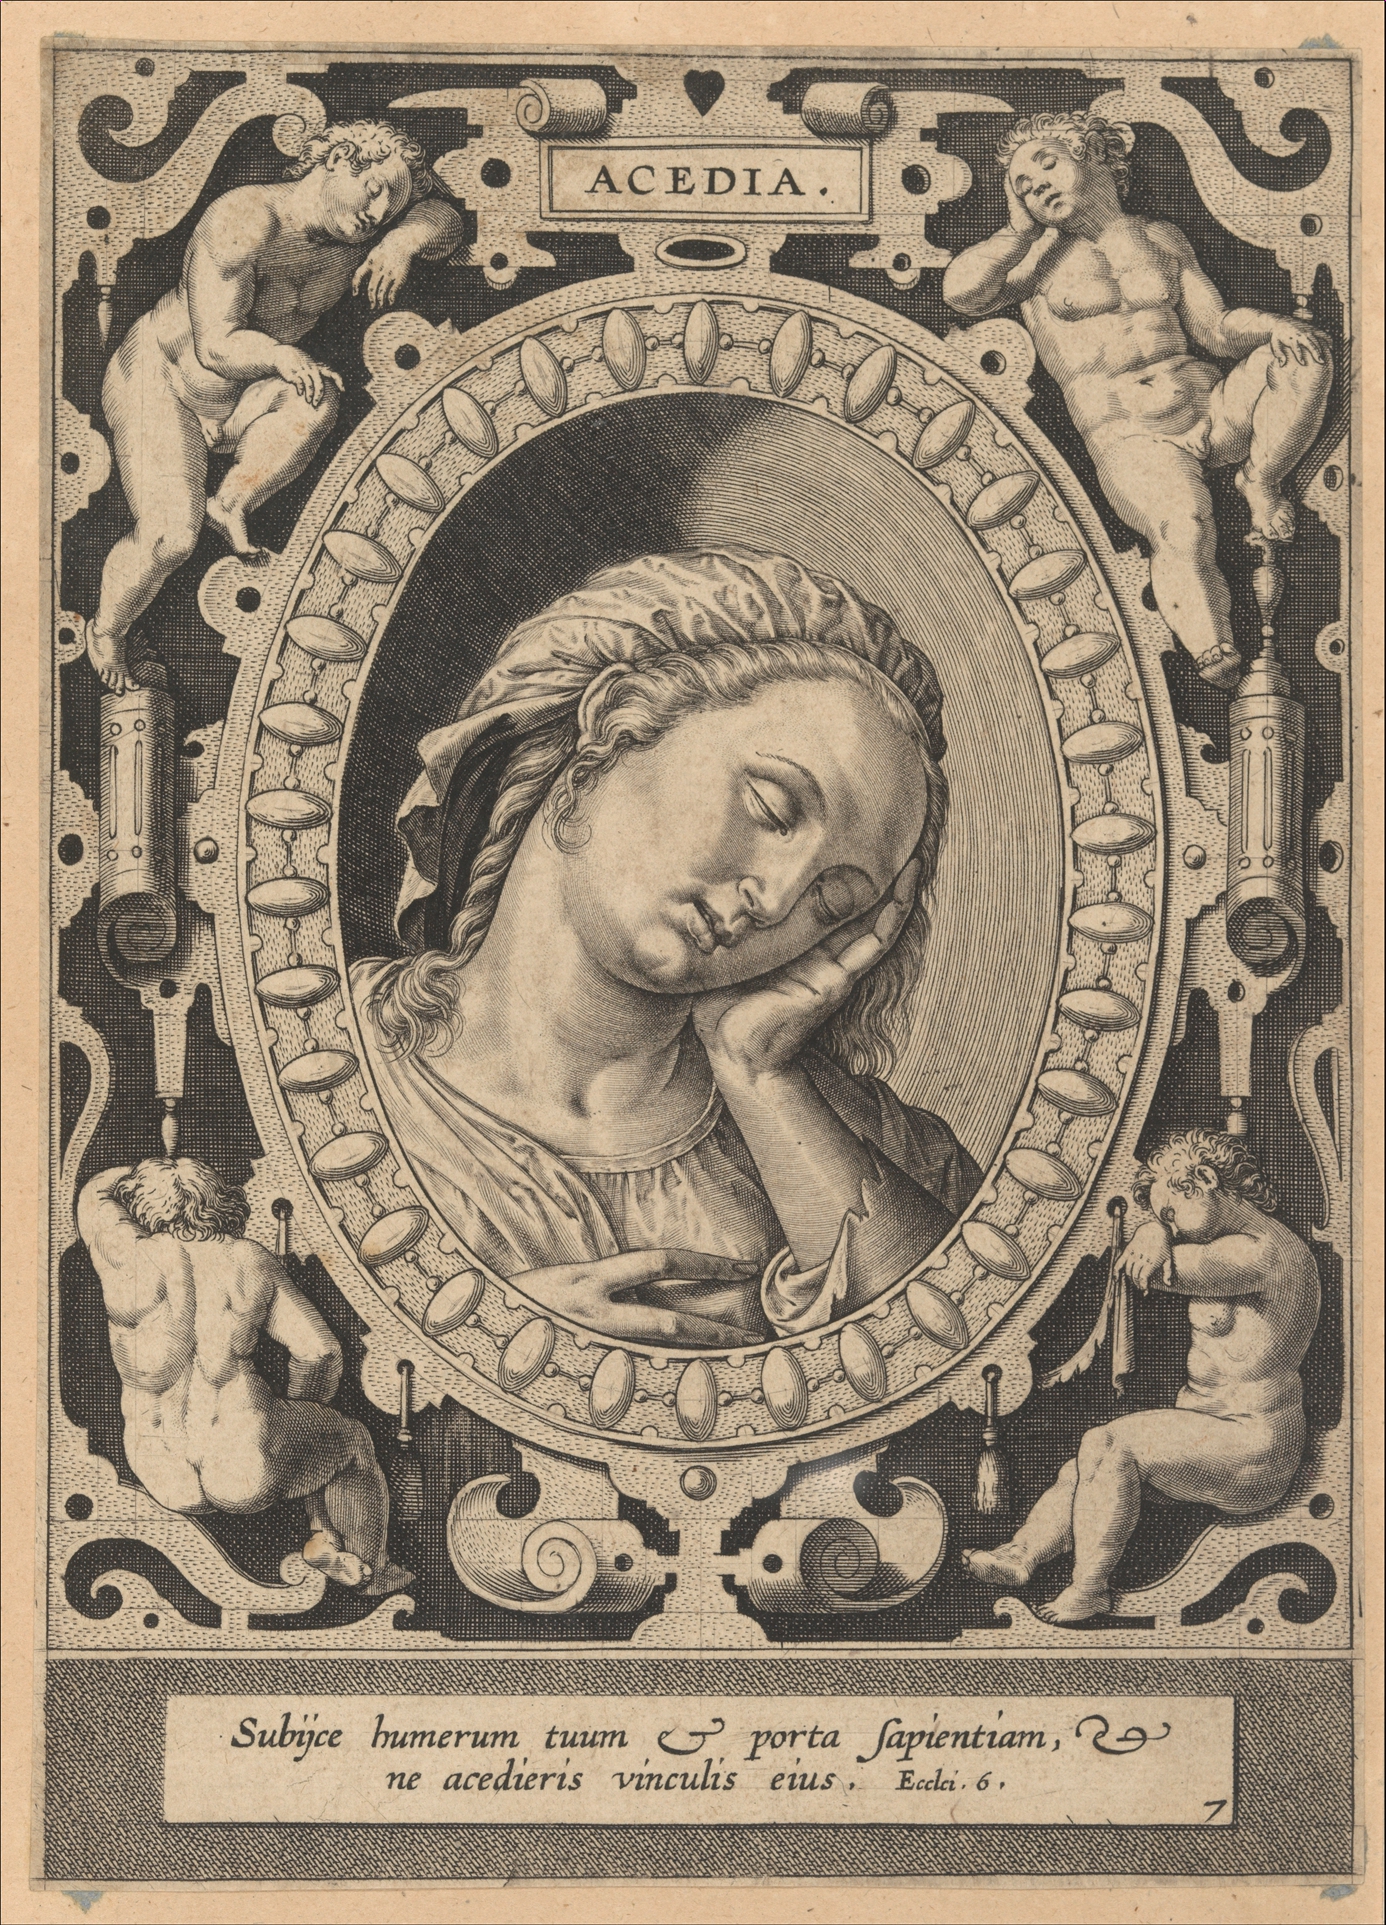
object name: print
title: Sloth (Acedia), from The Seven Vices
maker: hieronymus wierix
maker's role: artist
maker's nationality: netherlandish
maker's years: 1553-1619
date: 1612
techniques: engraving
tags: boys,male nudes,portraits,women